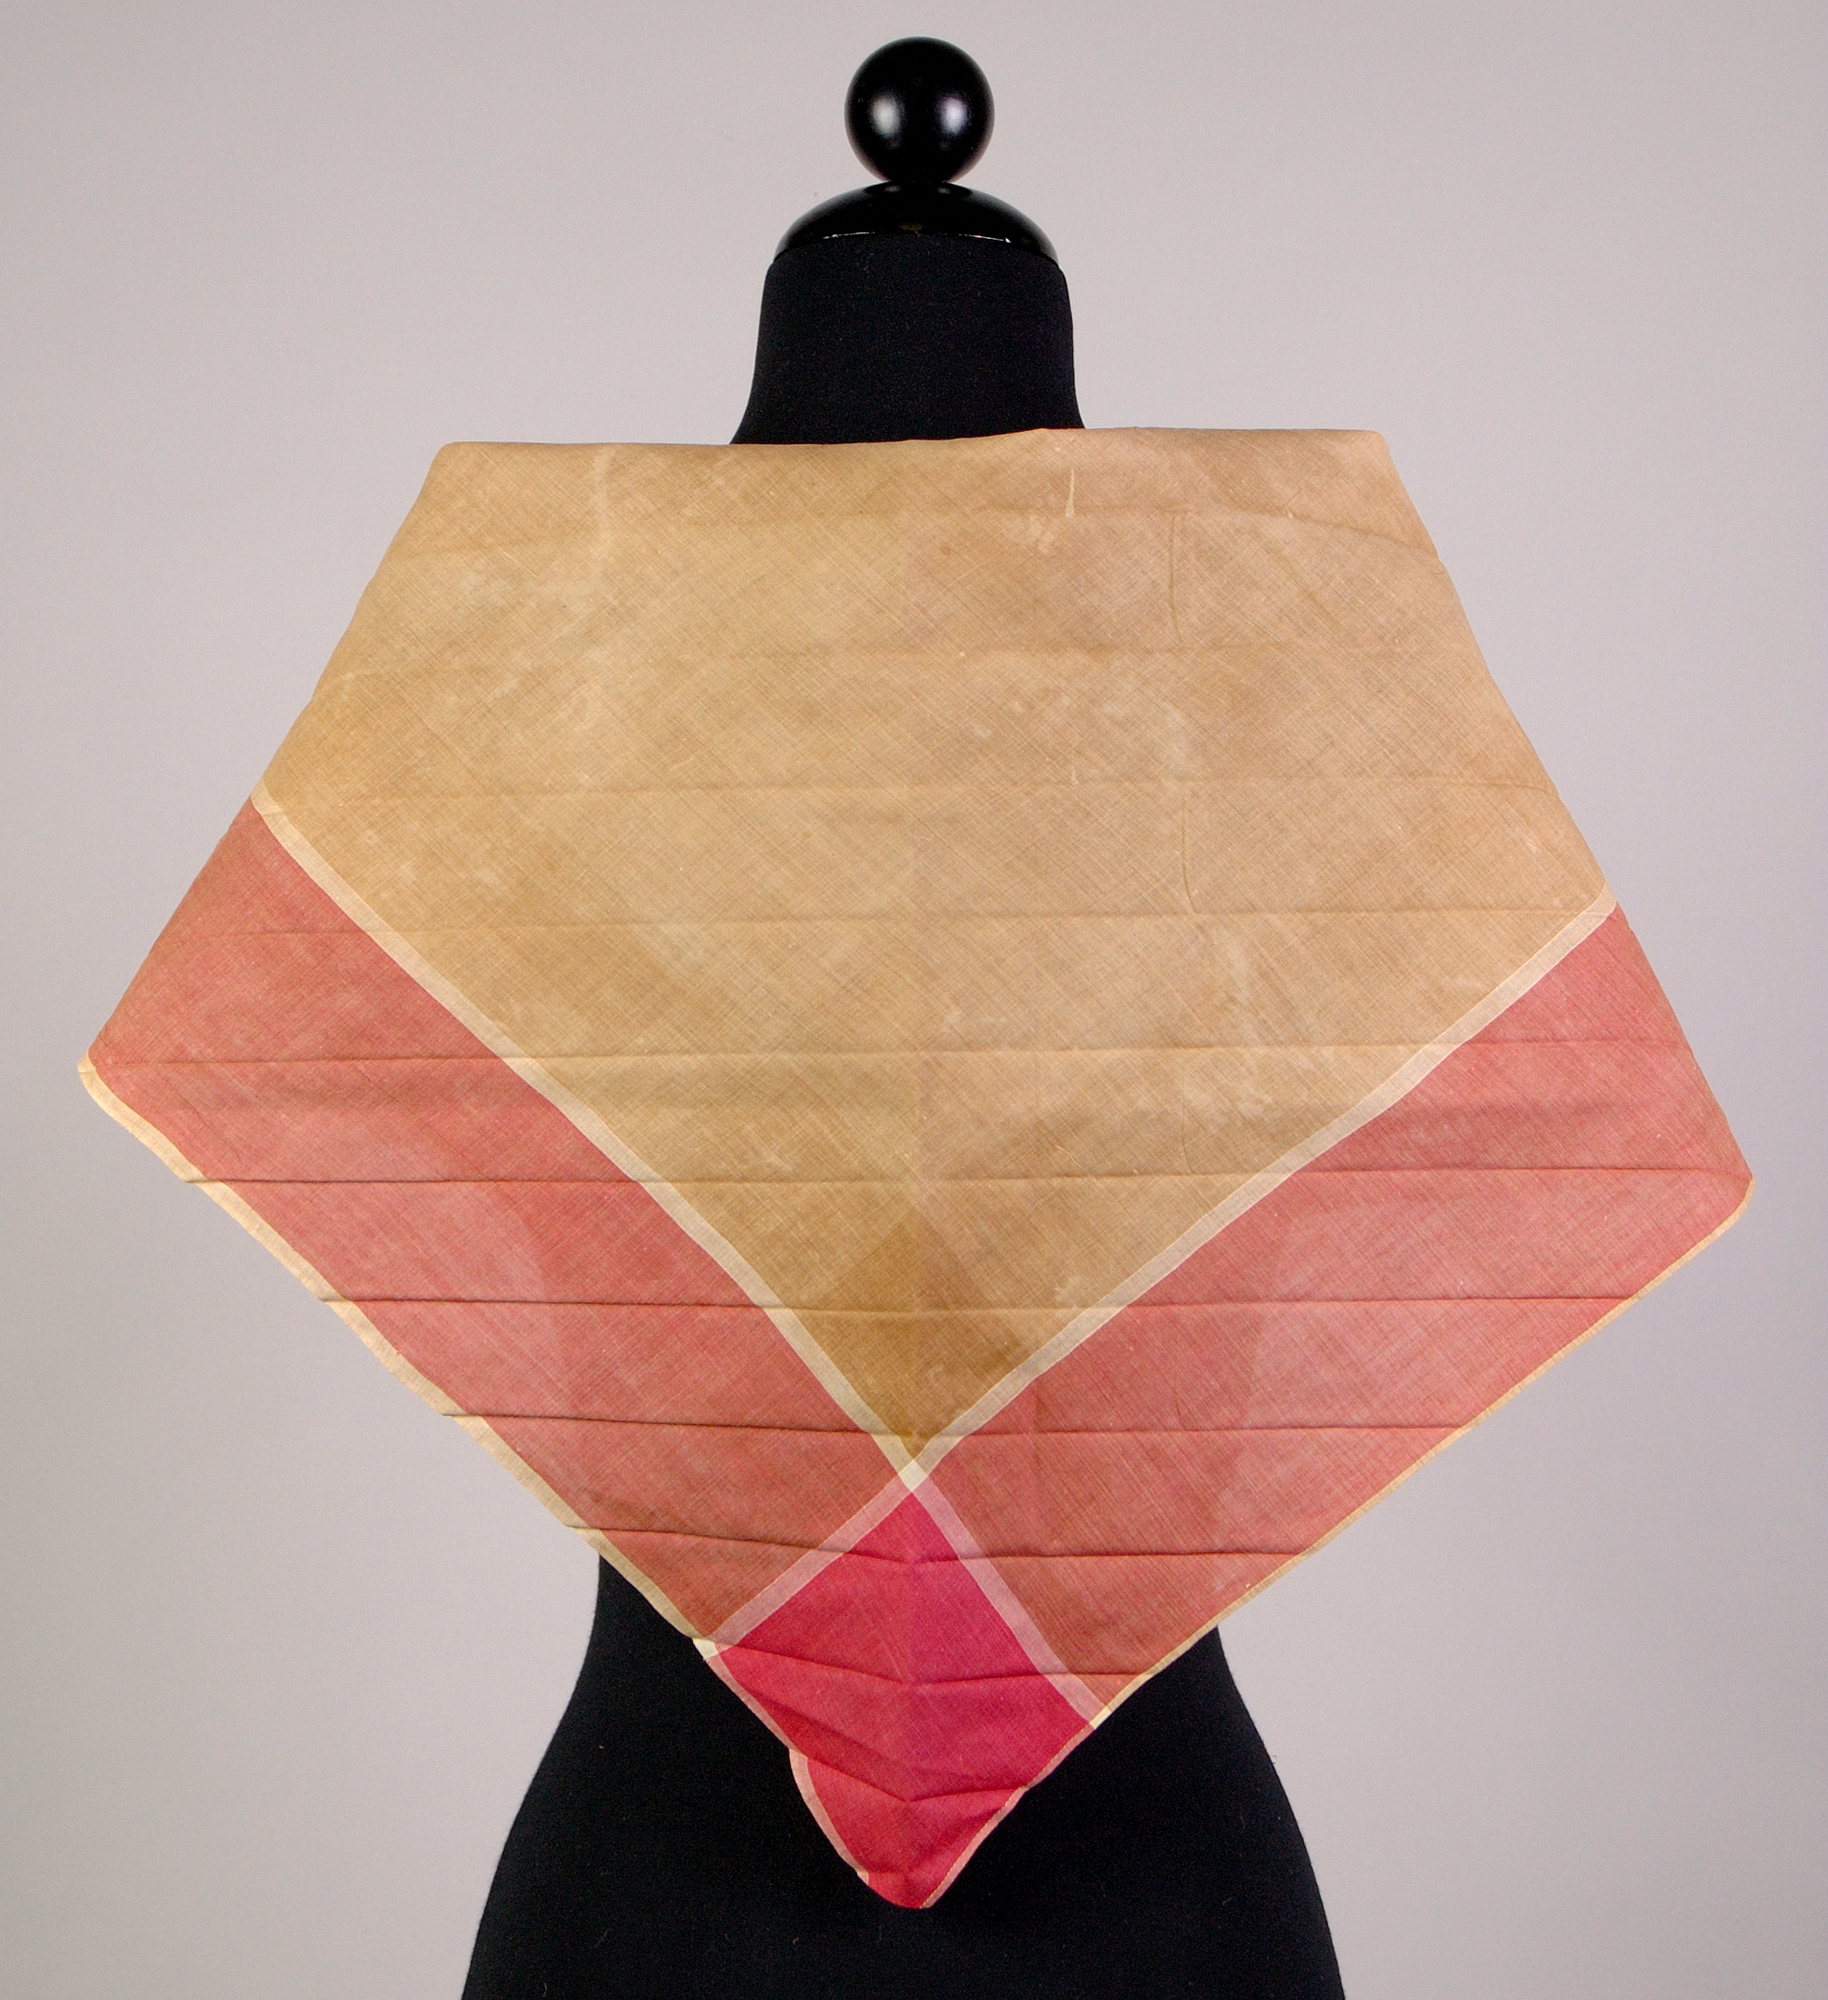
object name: cravat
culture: american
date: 1840-1850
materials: linen